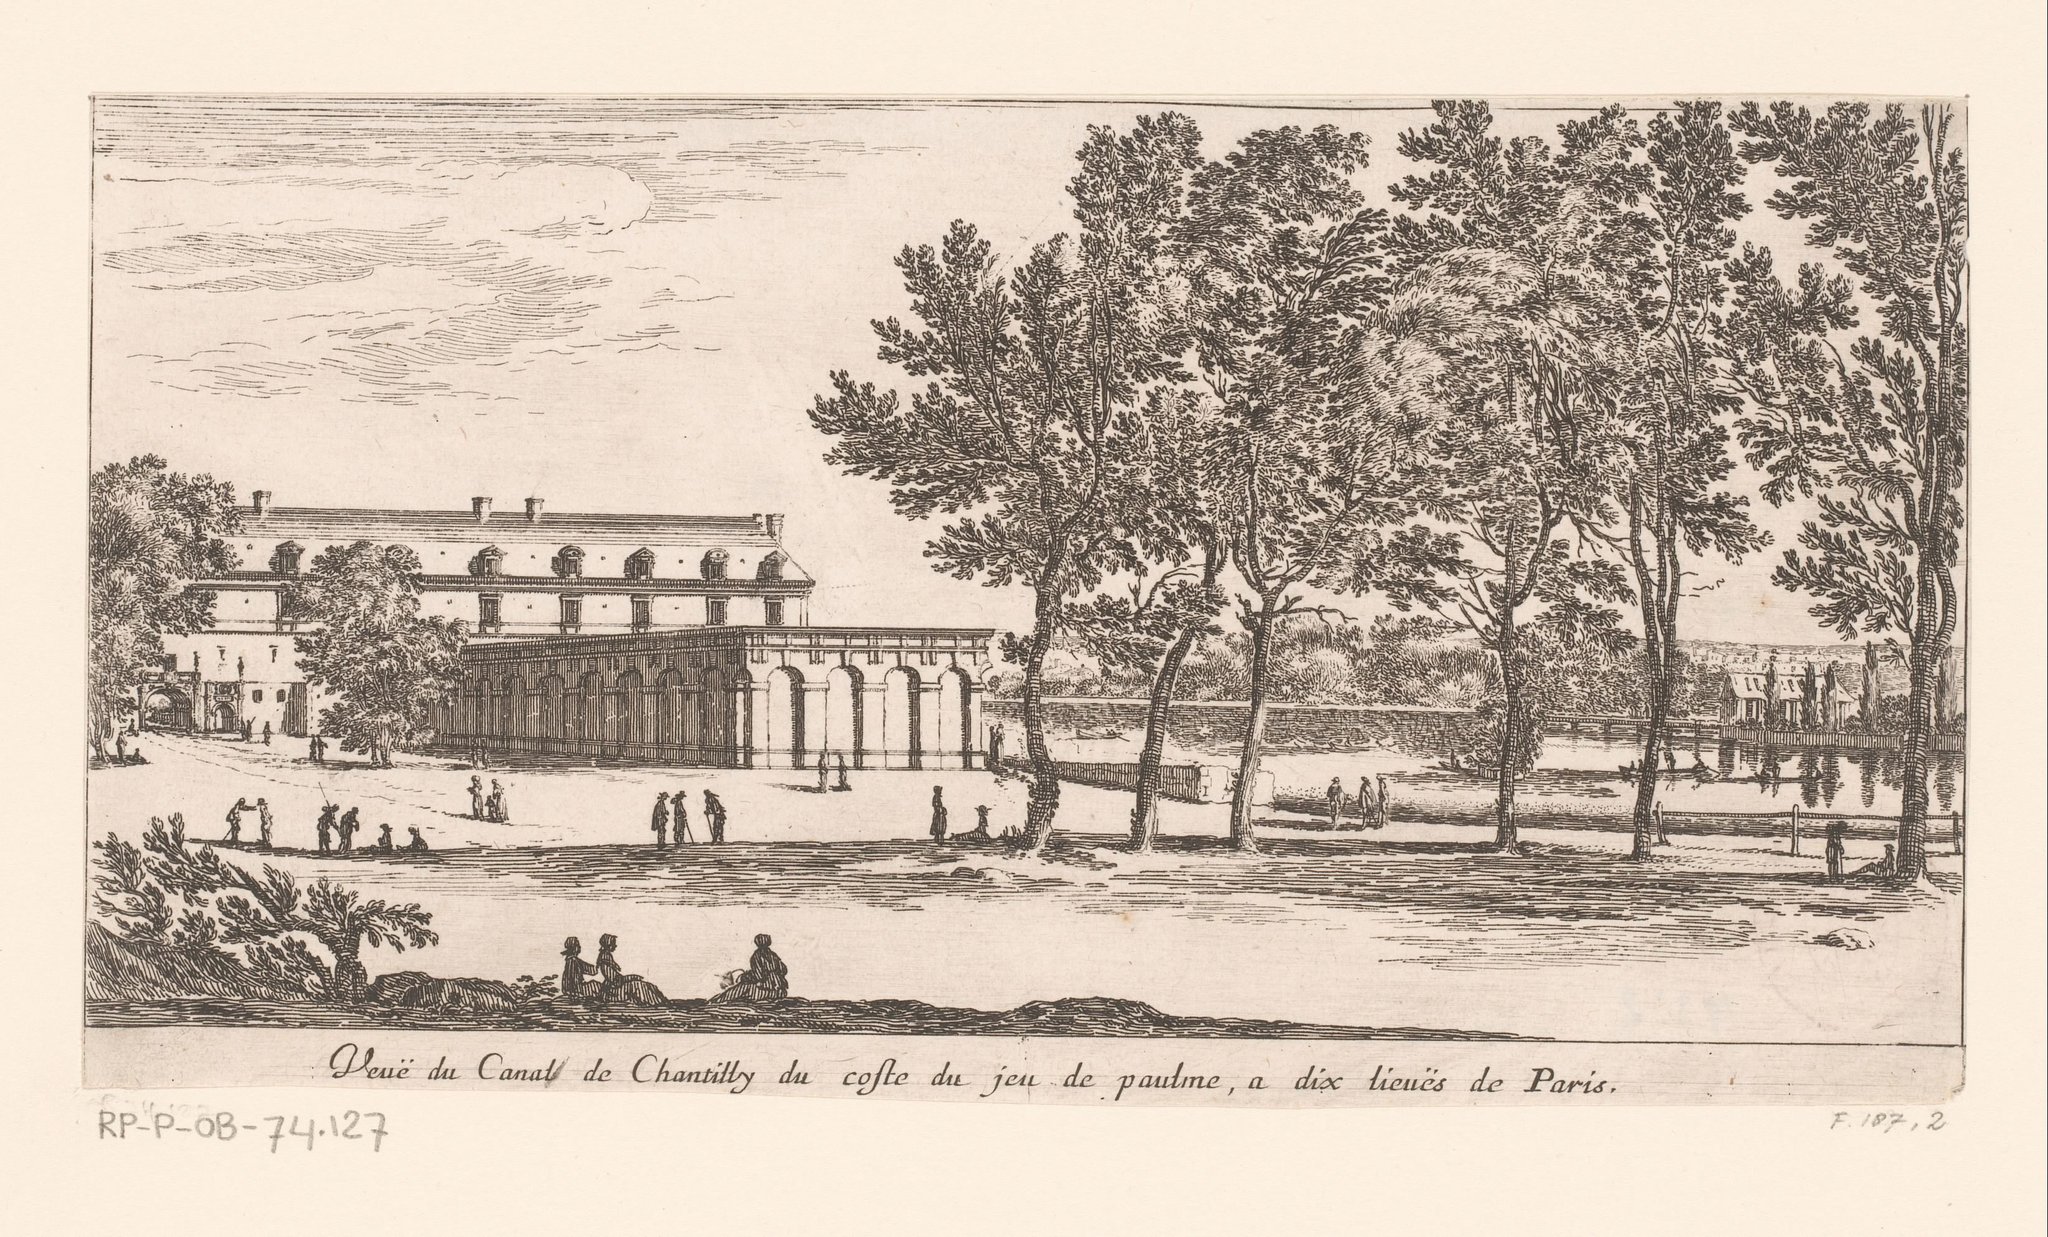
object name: print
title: Gezicht op het kanaal van Chantilly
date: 1631-1661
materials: paper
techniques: etching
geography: france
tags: canal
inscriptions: collector's mark: Lugt 240